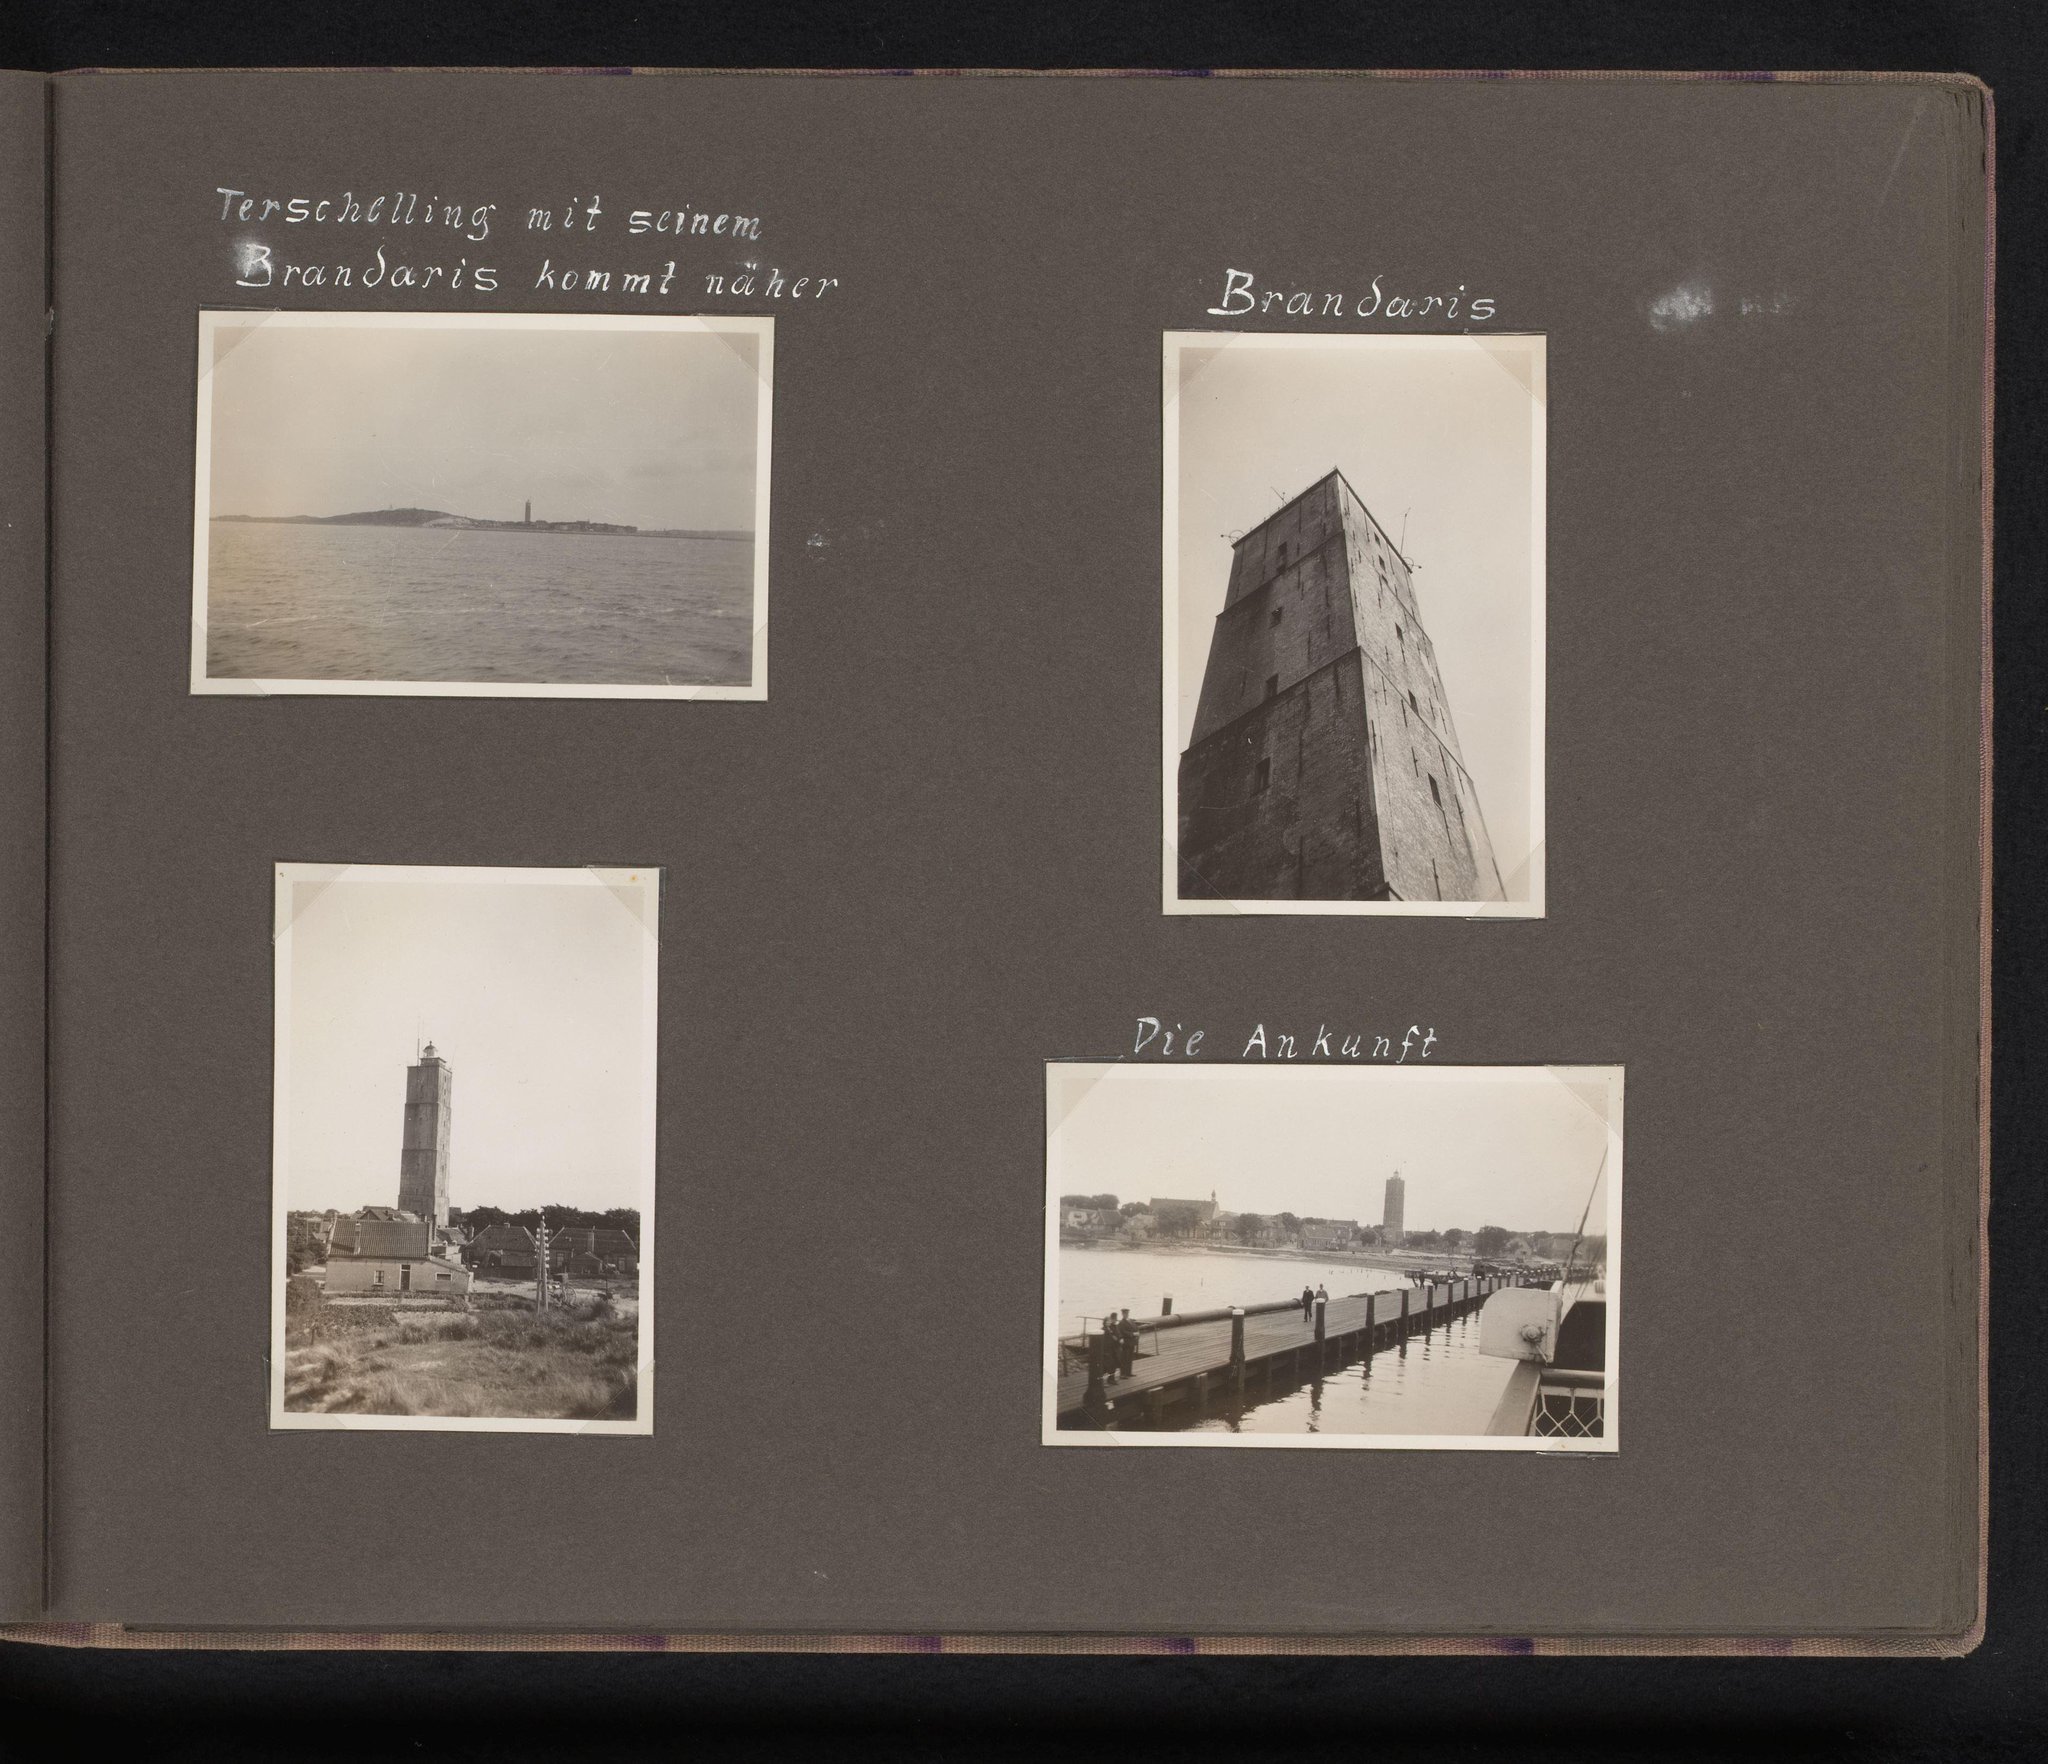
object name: album leaf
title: Vier gezichten op Terschelling met de vuurtoren Brandaris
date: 1905-1931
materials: cardboard, paper, photographic support, plastic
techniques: gelatin silver print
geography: terschelling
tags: lighthouse, lightship, city-view in general; 'veduta'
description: Foto's gemaakt tijdens de huwelijksreis van Berti Hoppe en Herman Besselaar. Deze pagina maakt deel uit van een album.